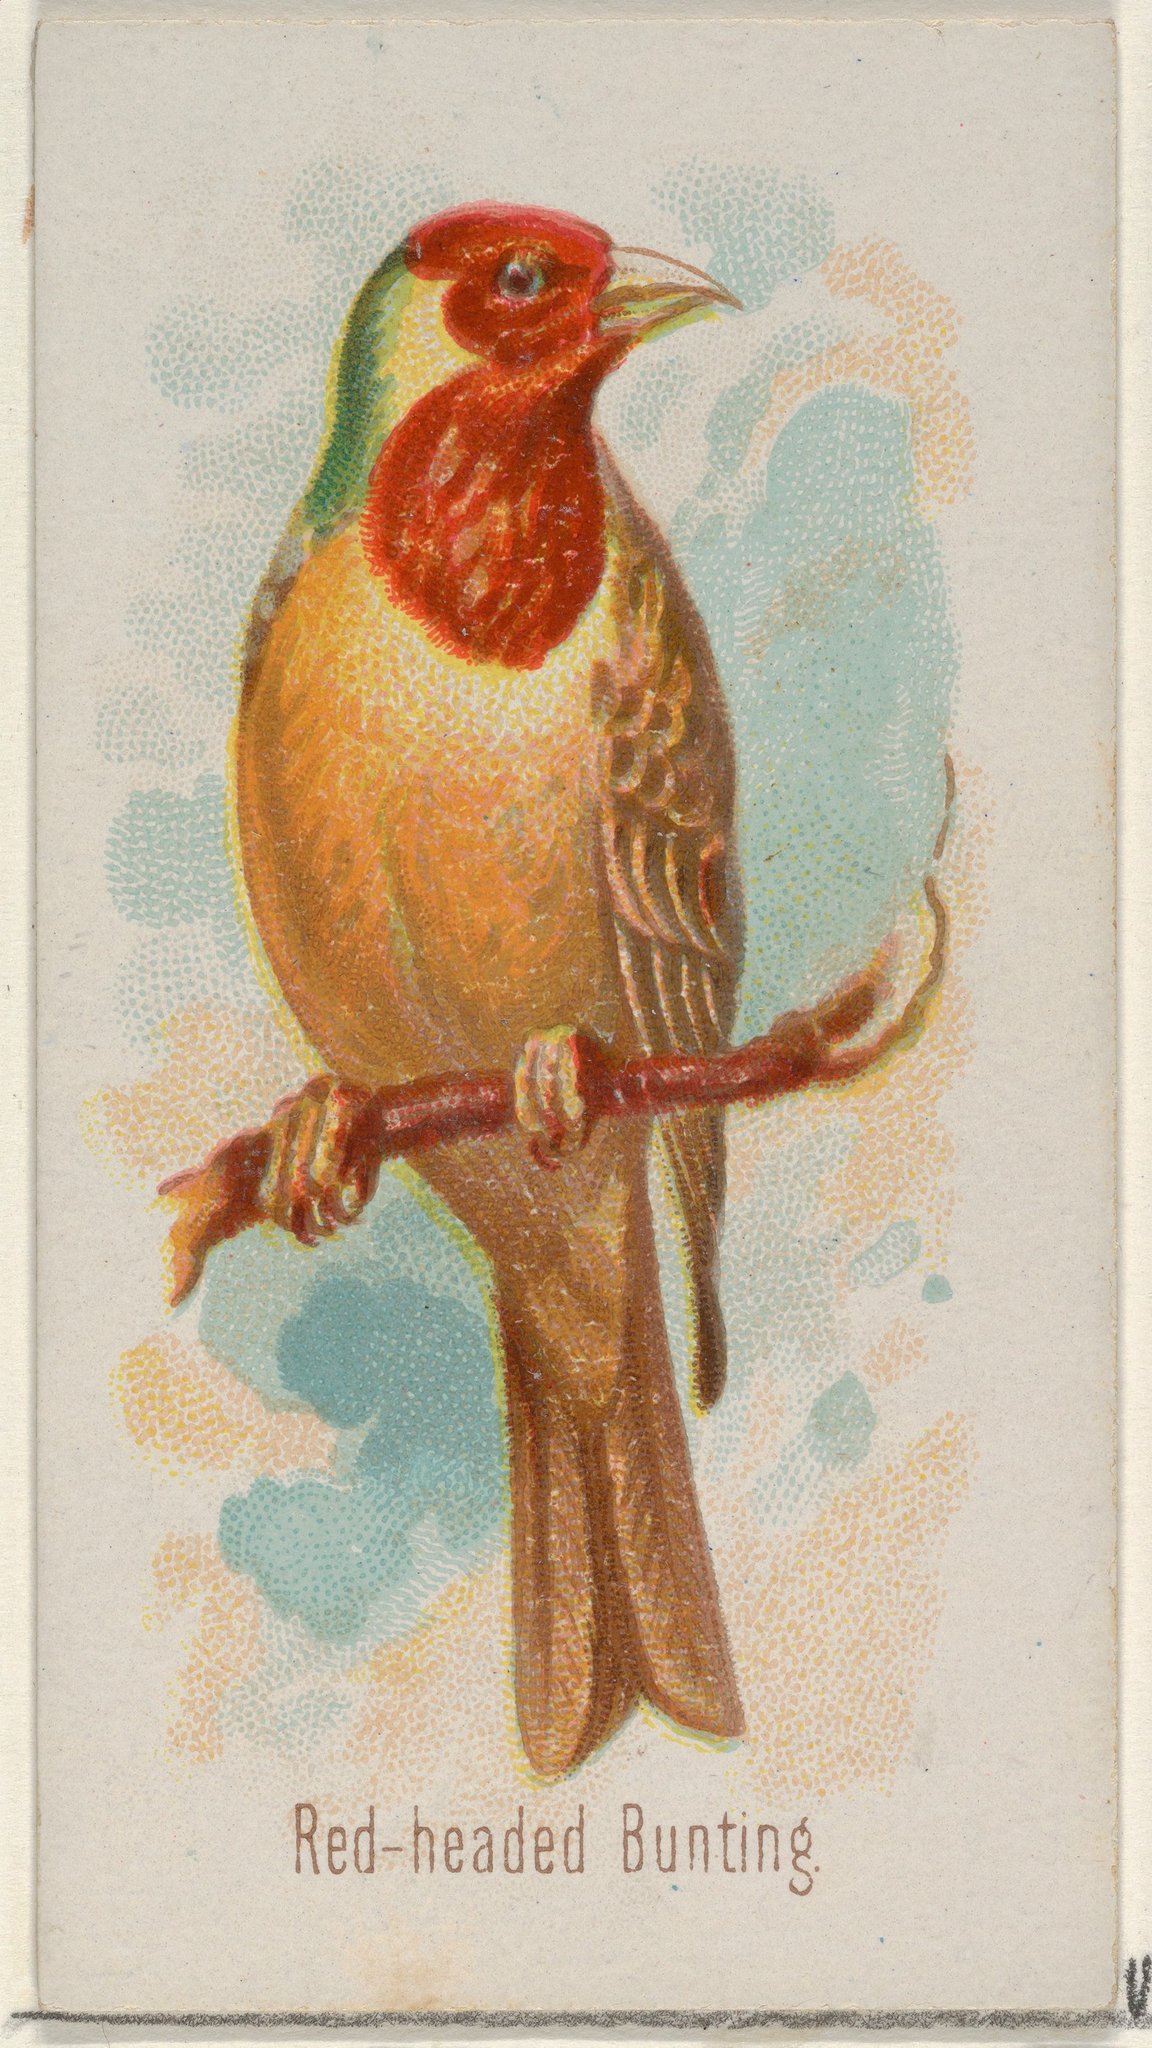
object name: print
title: Red-headed Bunting, from the Song Birds of the World series (N23) for Allen & Ginter Cigarettes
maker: allen & ginter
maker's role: publisher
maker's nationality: american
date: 1890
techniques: color lithograph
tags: birds